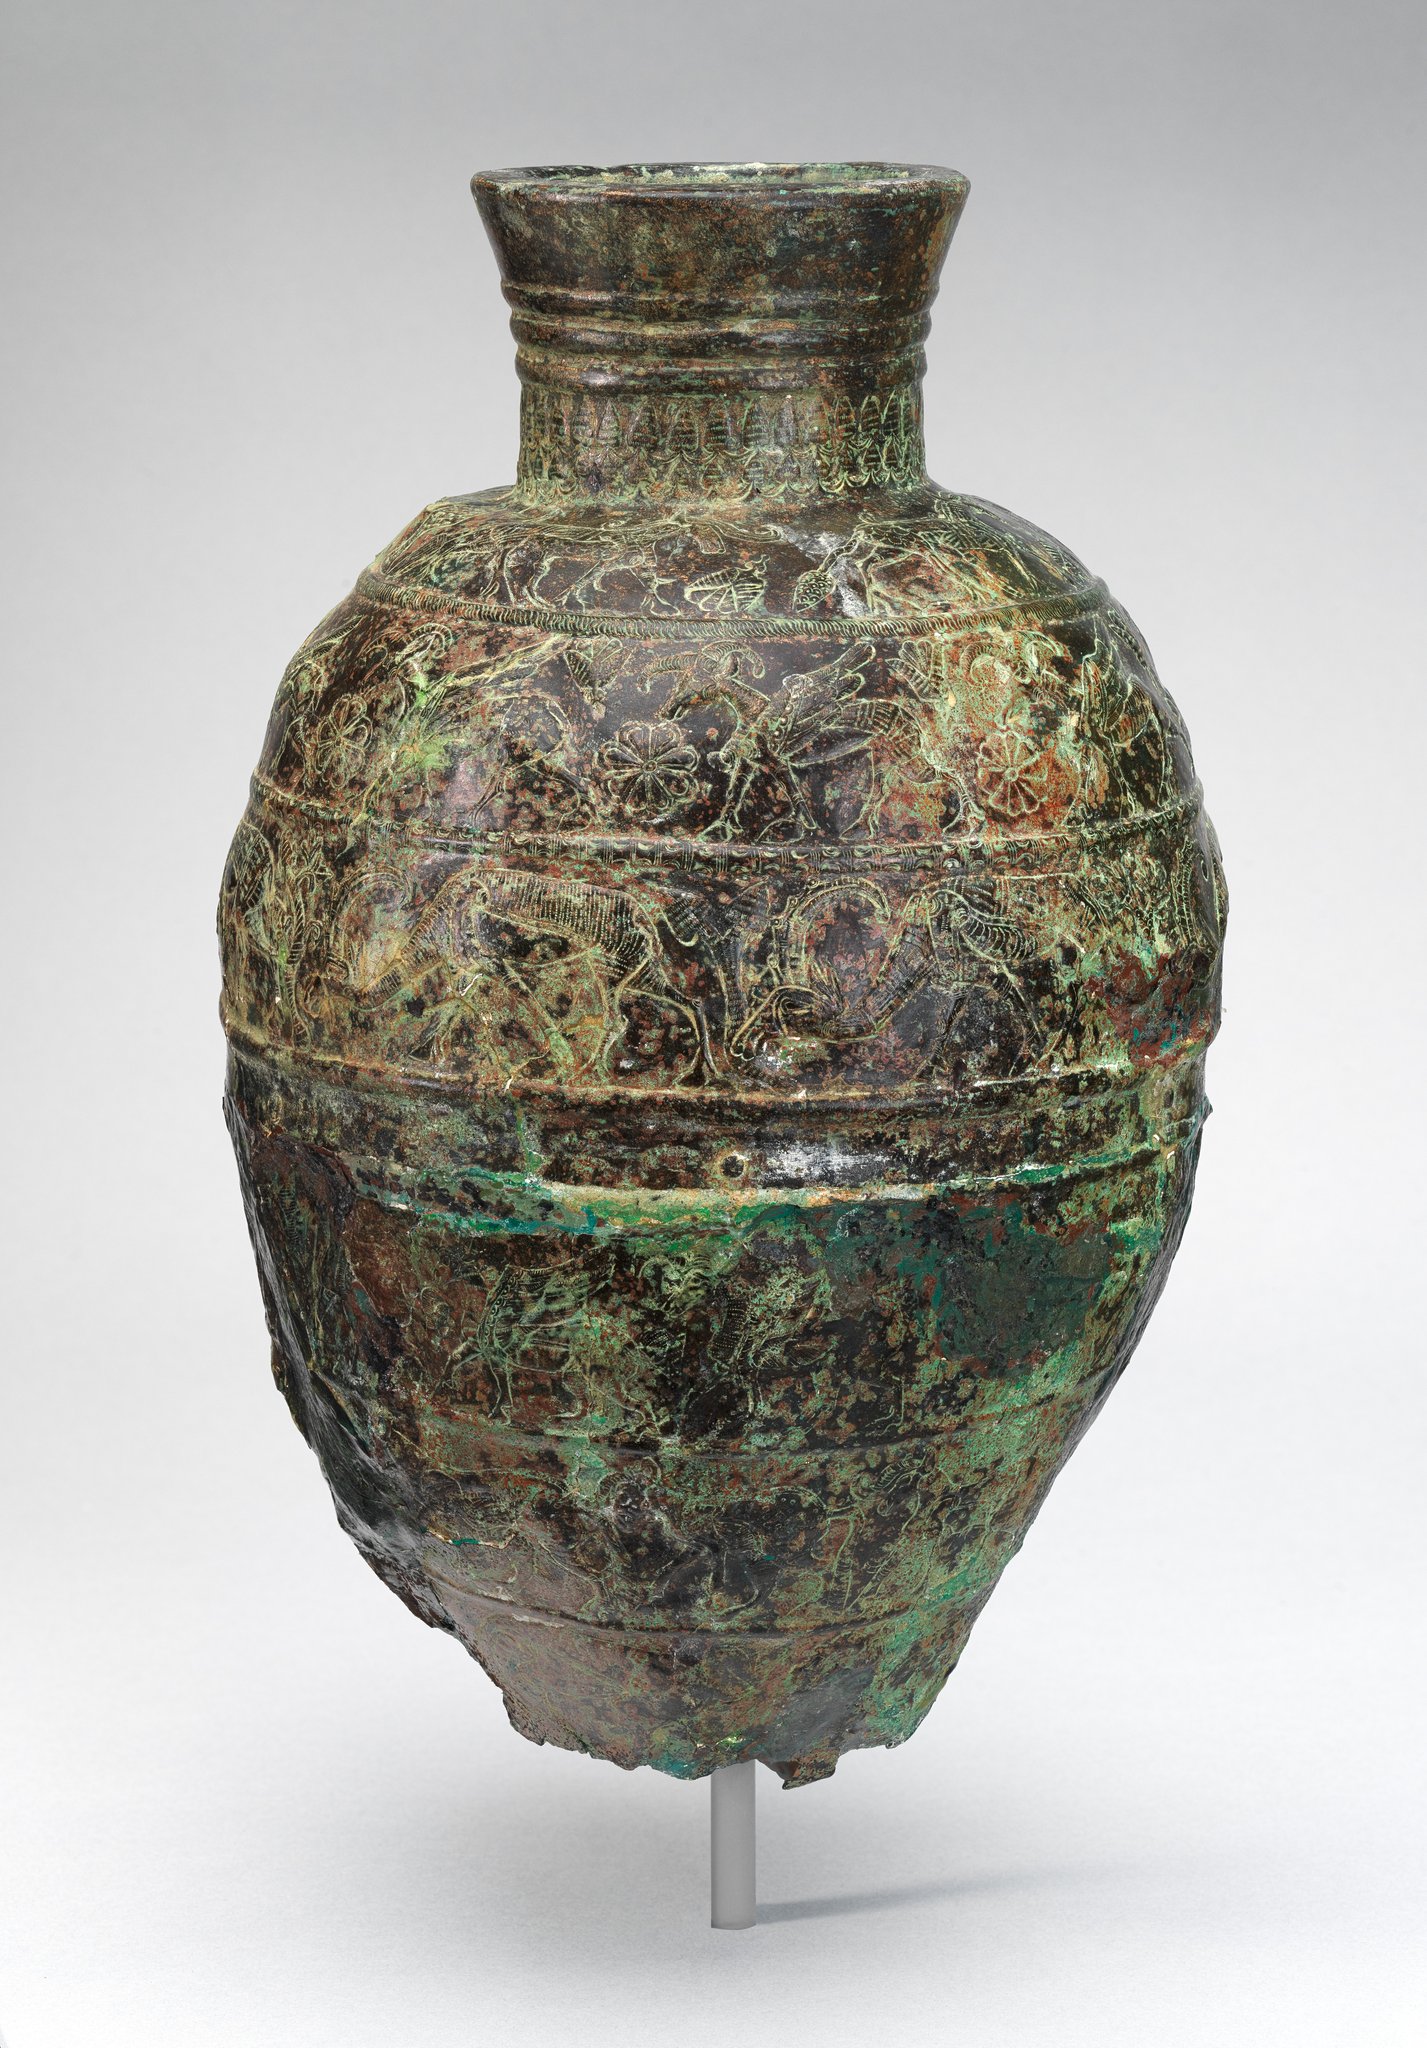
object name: vessel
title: Vessel with six animal friezes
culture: iranian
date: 1000-701 BCE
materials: bronze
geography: northwestern iran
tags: animals